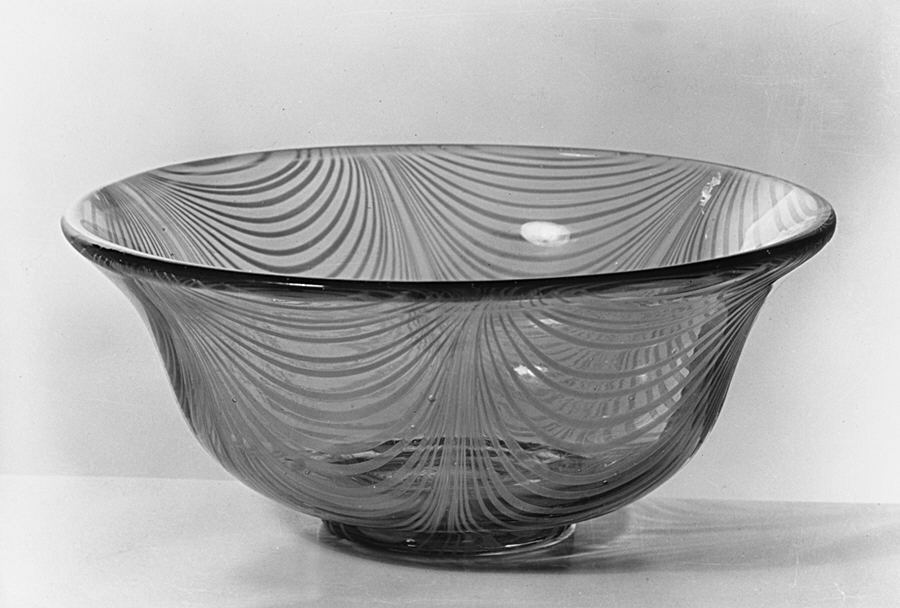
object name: bowl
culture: american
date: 1850-1875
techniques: glassblowing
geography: united states